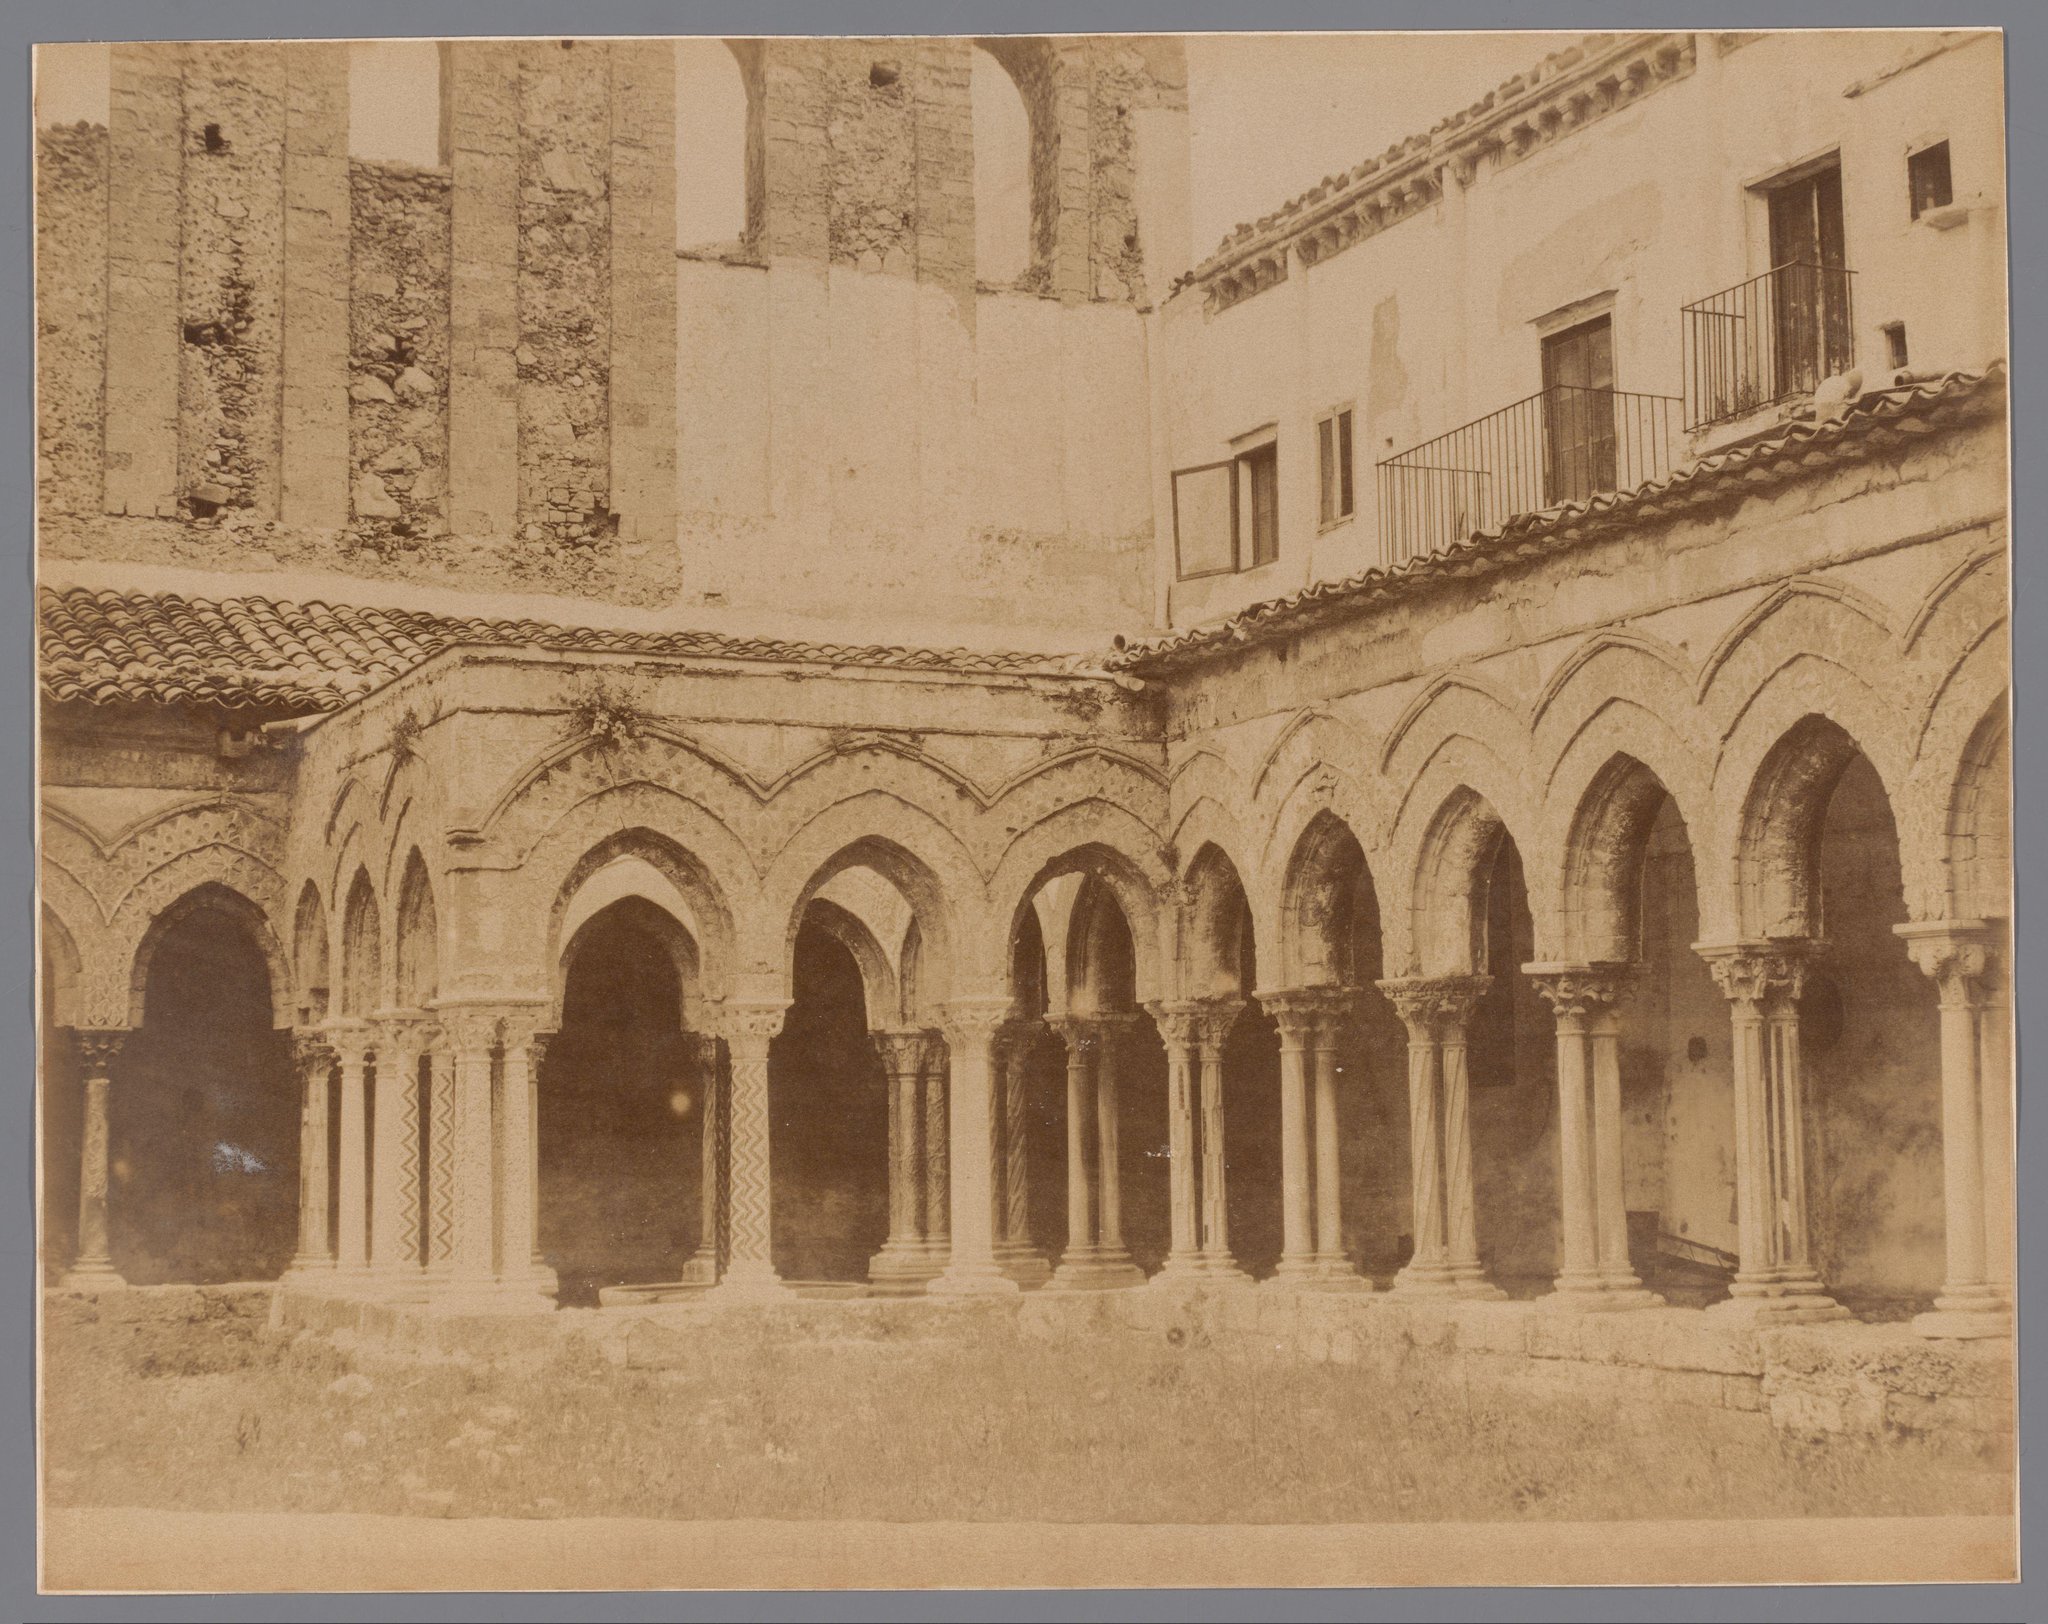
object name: photograph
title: Kloostergang van de dom van Monreale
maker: giuseppe incorpora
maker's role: fotograaf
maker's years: 1834-1914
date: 1856-1914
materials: cardboard, paper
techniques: albumen print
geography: monreale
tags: abbey, monastery, convent ~ roman catholic church